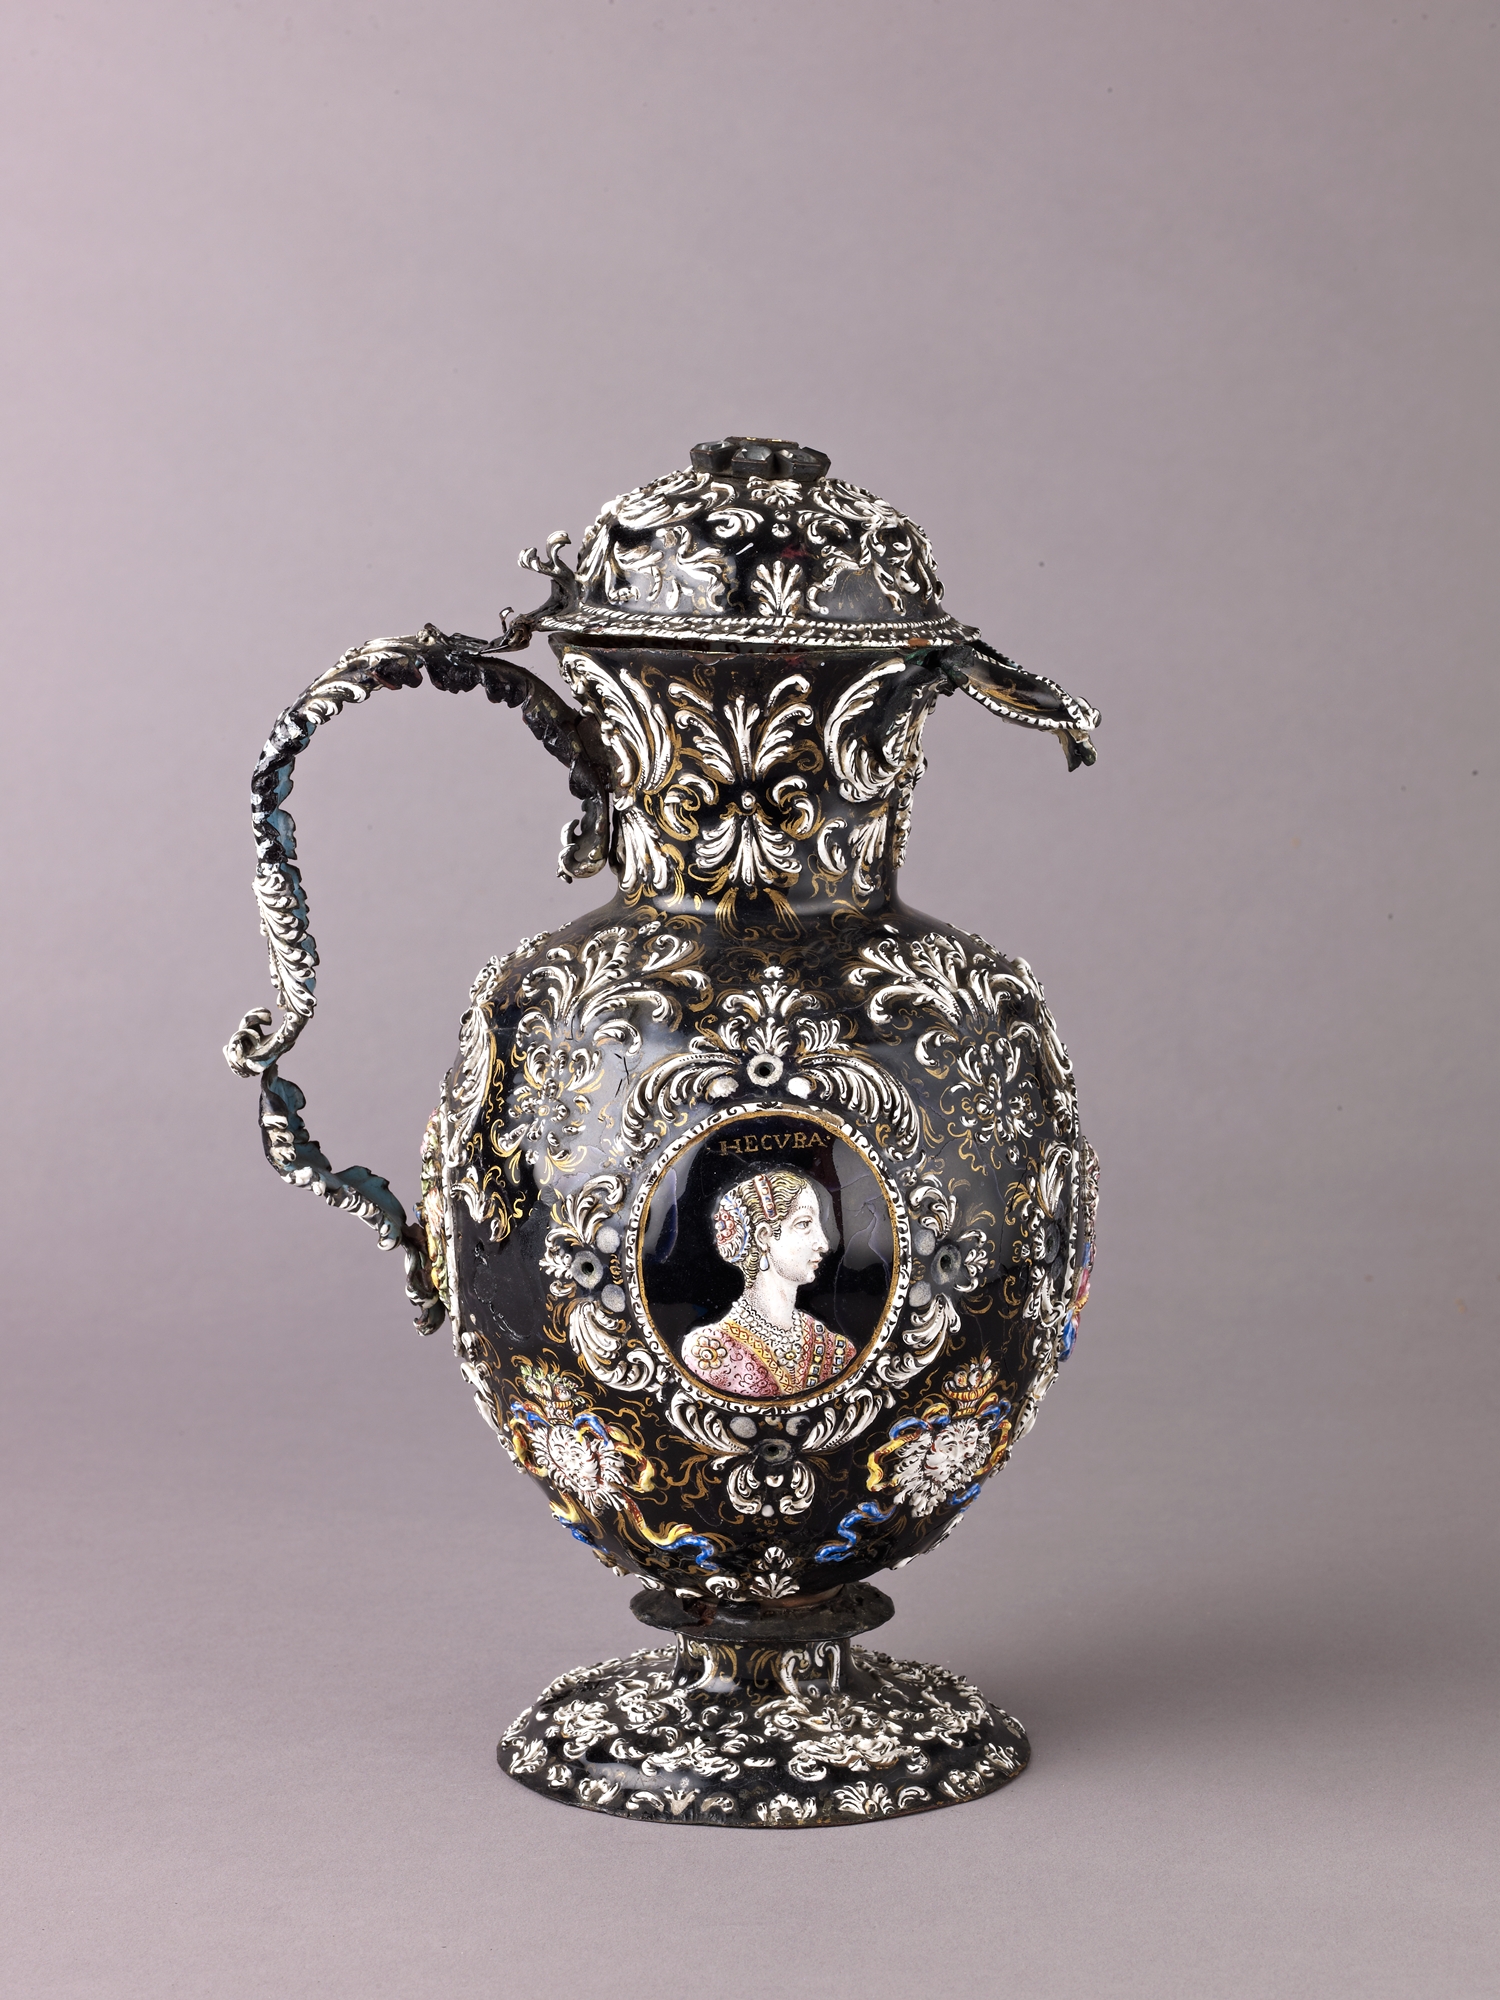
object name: pitcher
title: Ewer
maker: jacques nouailher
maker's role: artist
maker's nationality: french, limoges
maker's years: 1605-1674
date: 1670-1674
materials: copper, enamel, gilt, paste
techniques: painting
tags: men,women